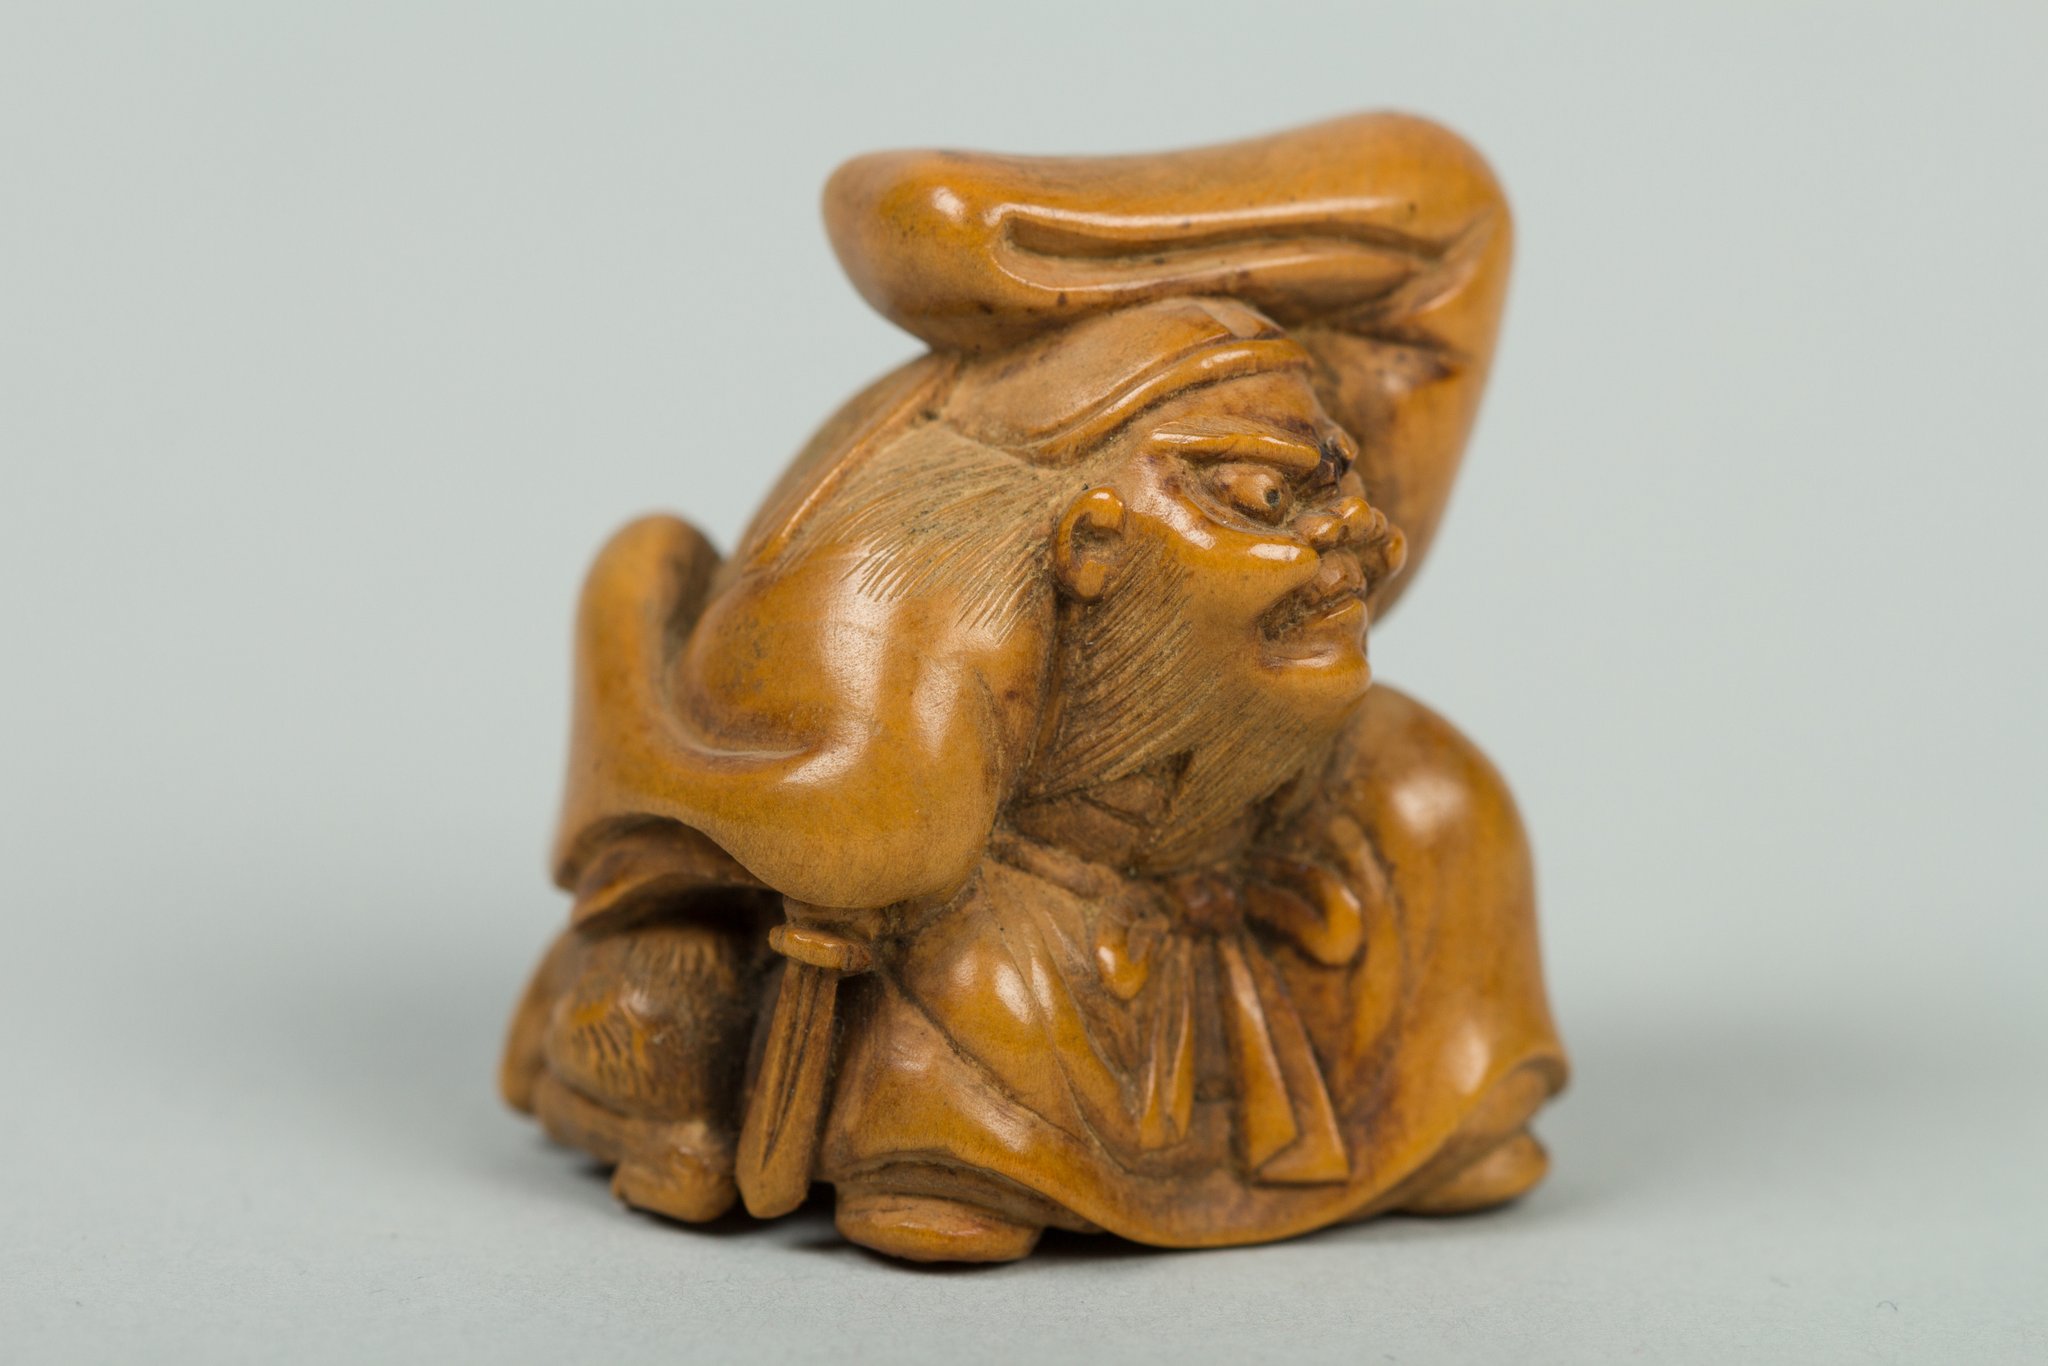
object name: netsuke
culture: japanese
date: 1801-1900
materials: wood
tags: men